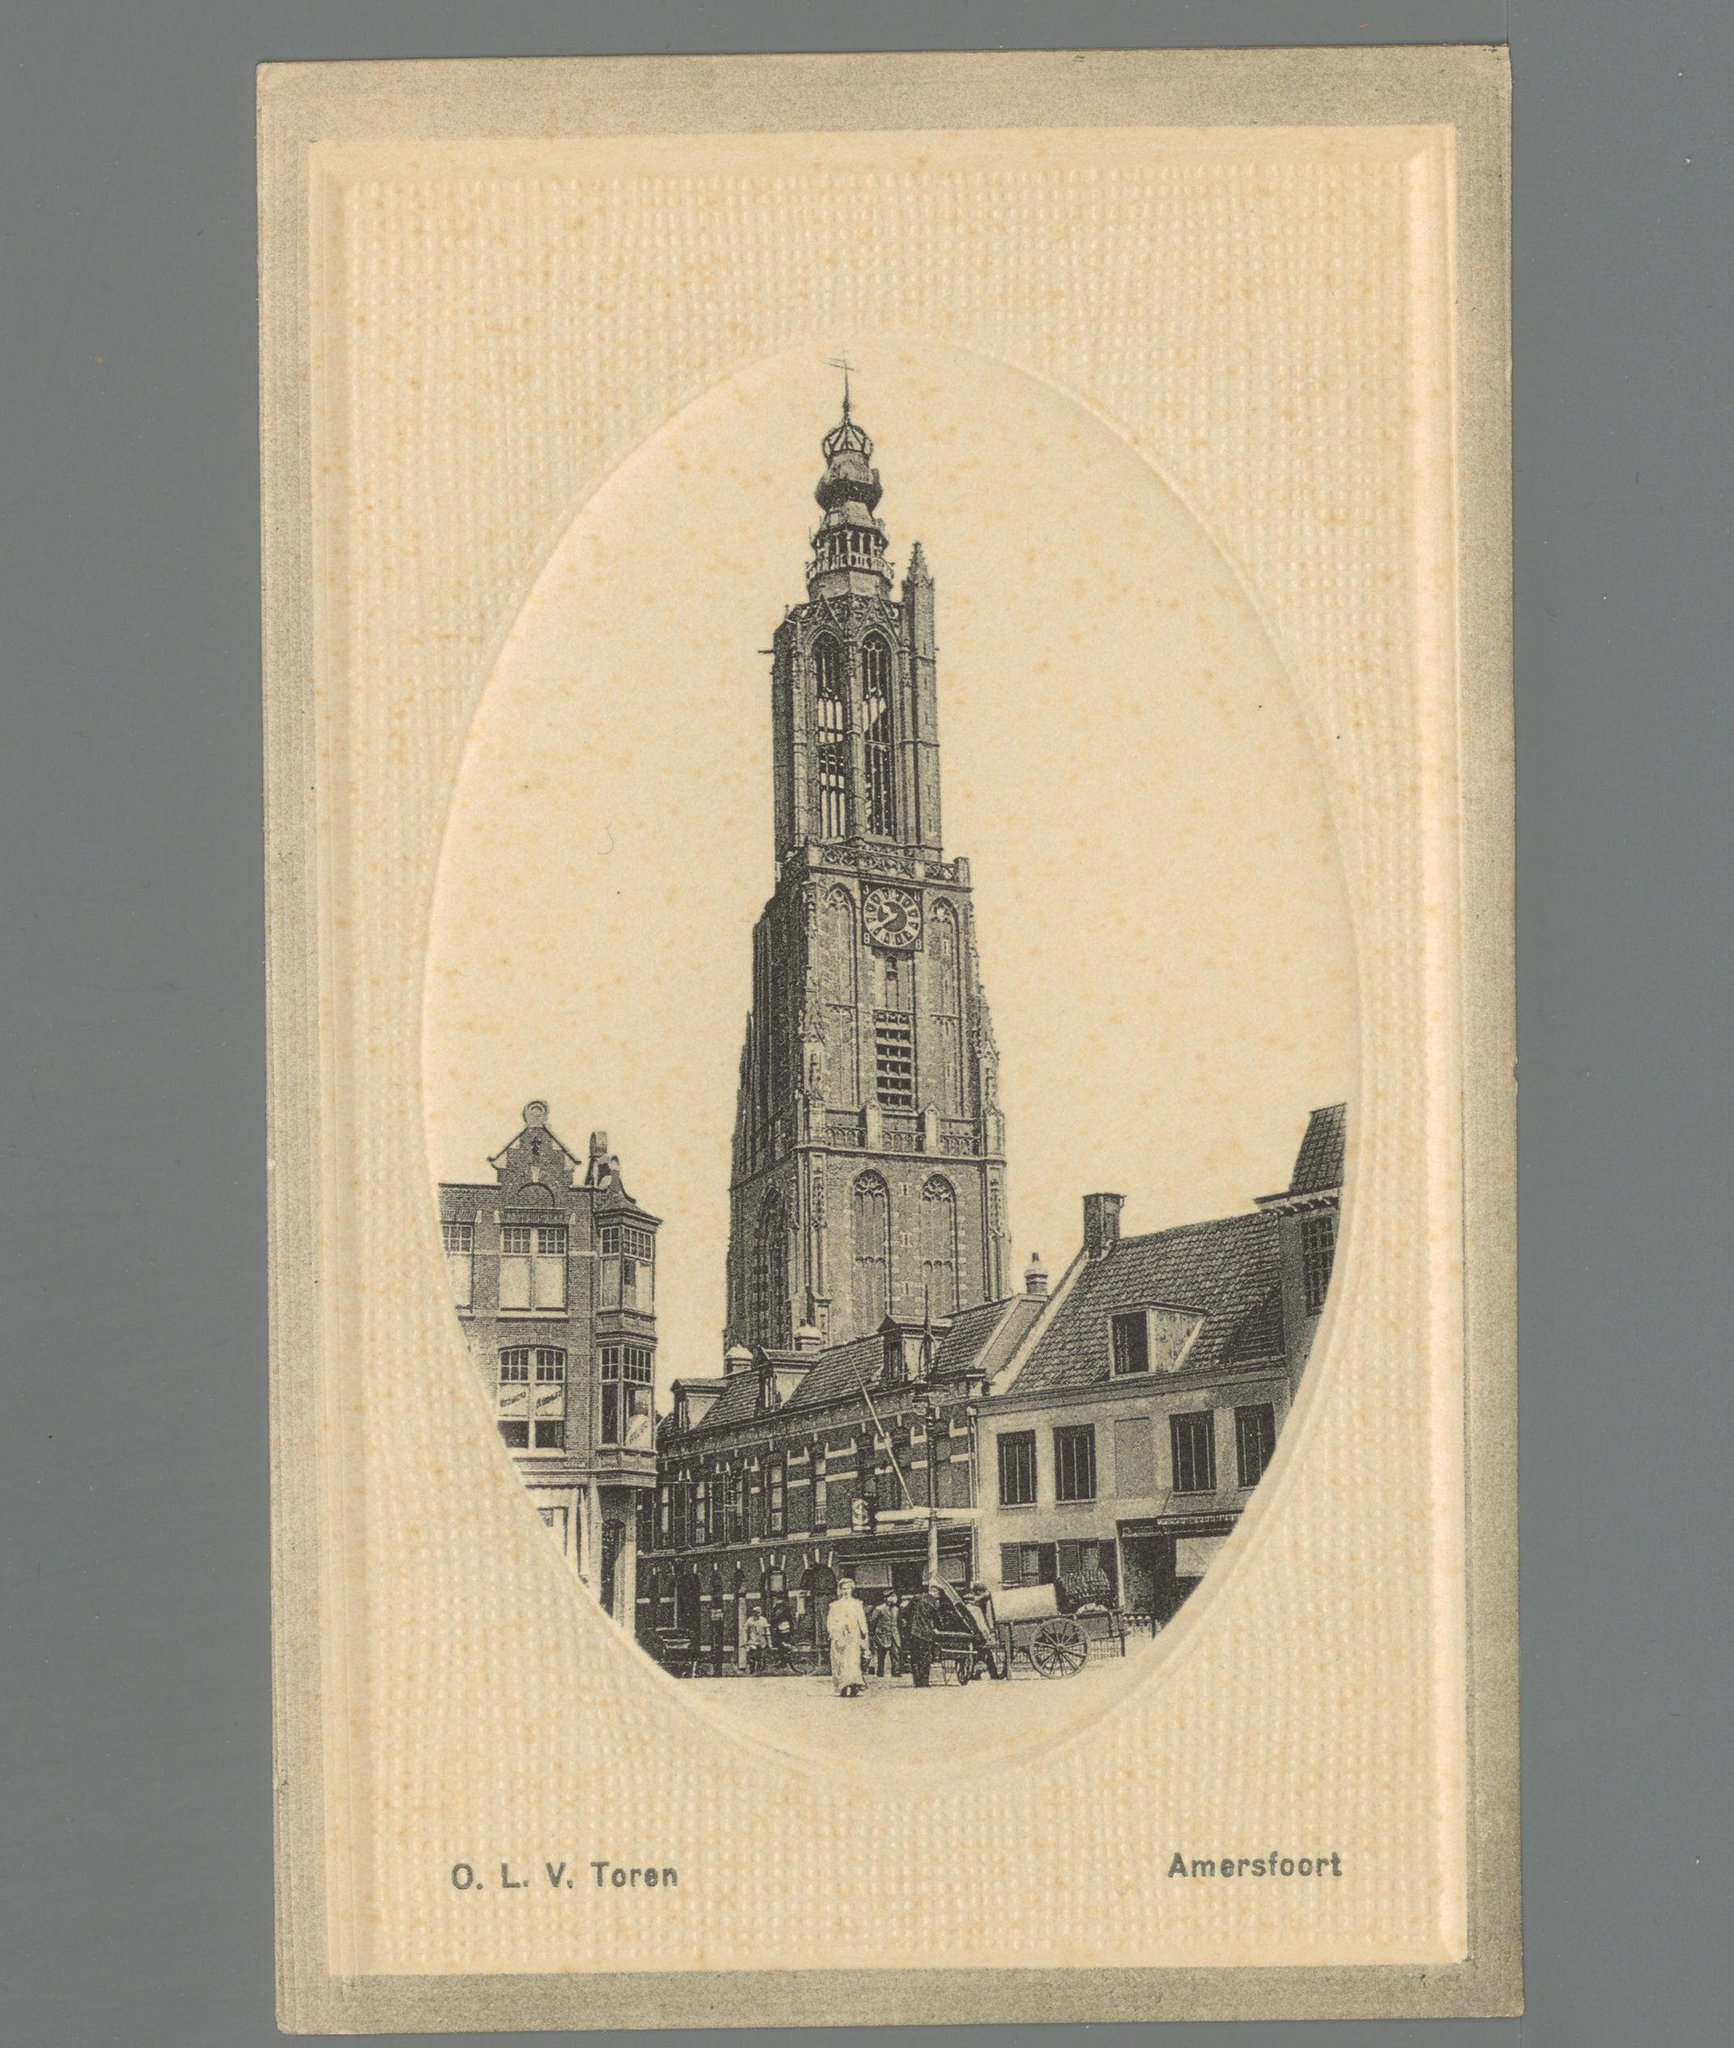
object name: ansichtkaart, prentbriefkaart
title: O. L. V. Toren. Amersfoort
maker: Anonymous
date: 1905-1930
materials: cardboard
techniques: photograph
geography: berlin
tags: church (exterior)